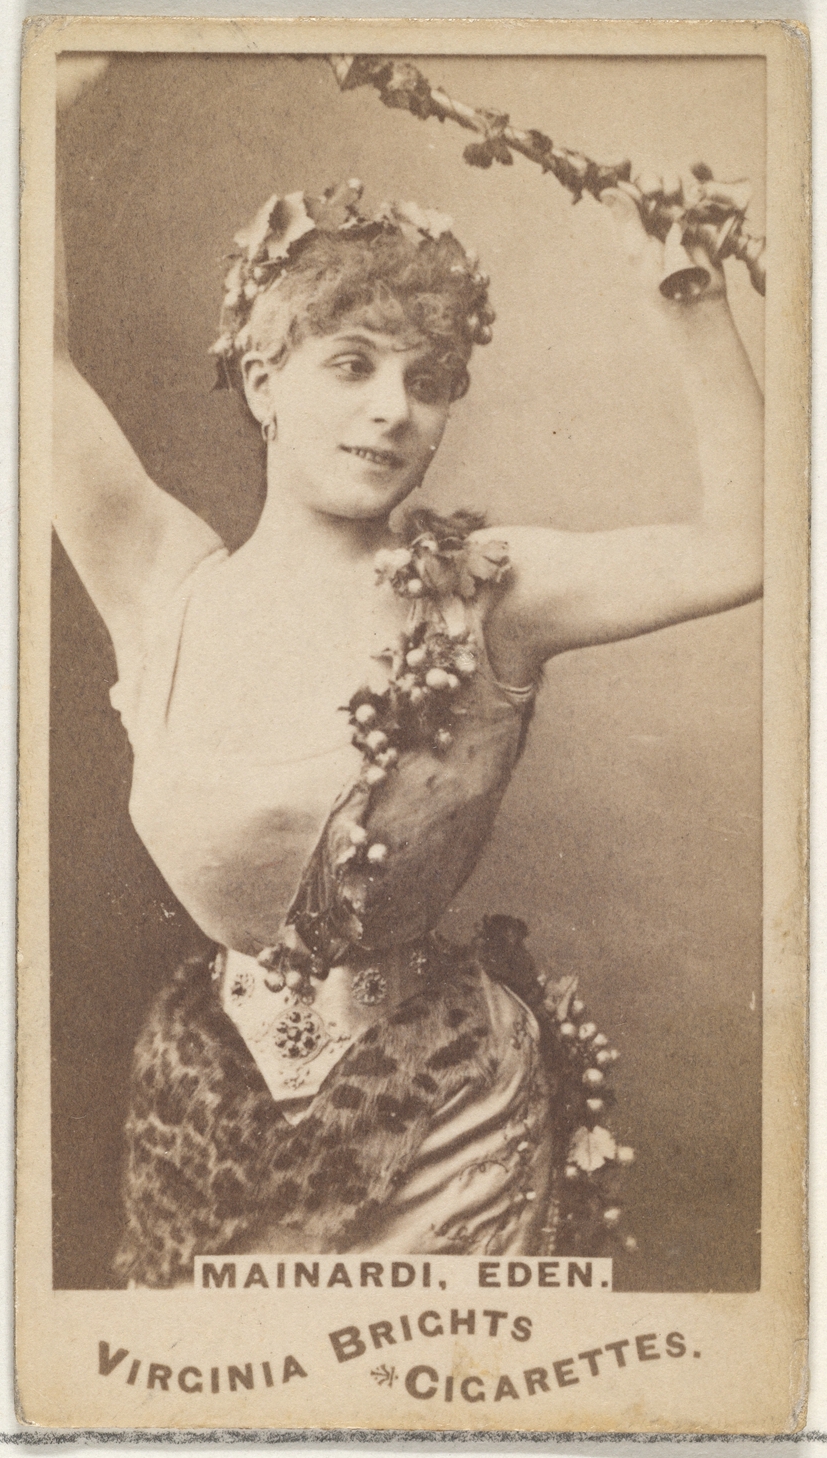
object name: photograph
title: Mainardi, Eden, from the Actors and Actresses series (N45, Type 1) for Virginia Brights Cigarettes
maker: allen & ginter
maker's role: publisher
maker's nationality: american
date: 1888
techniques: albumen silver print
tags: portraits,women,actresses